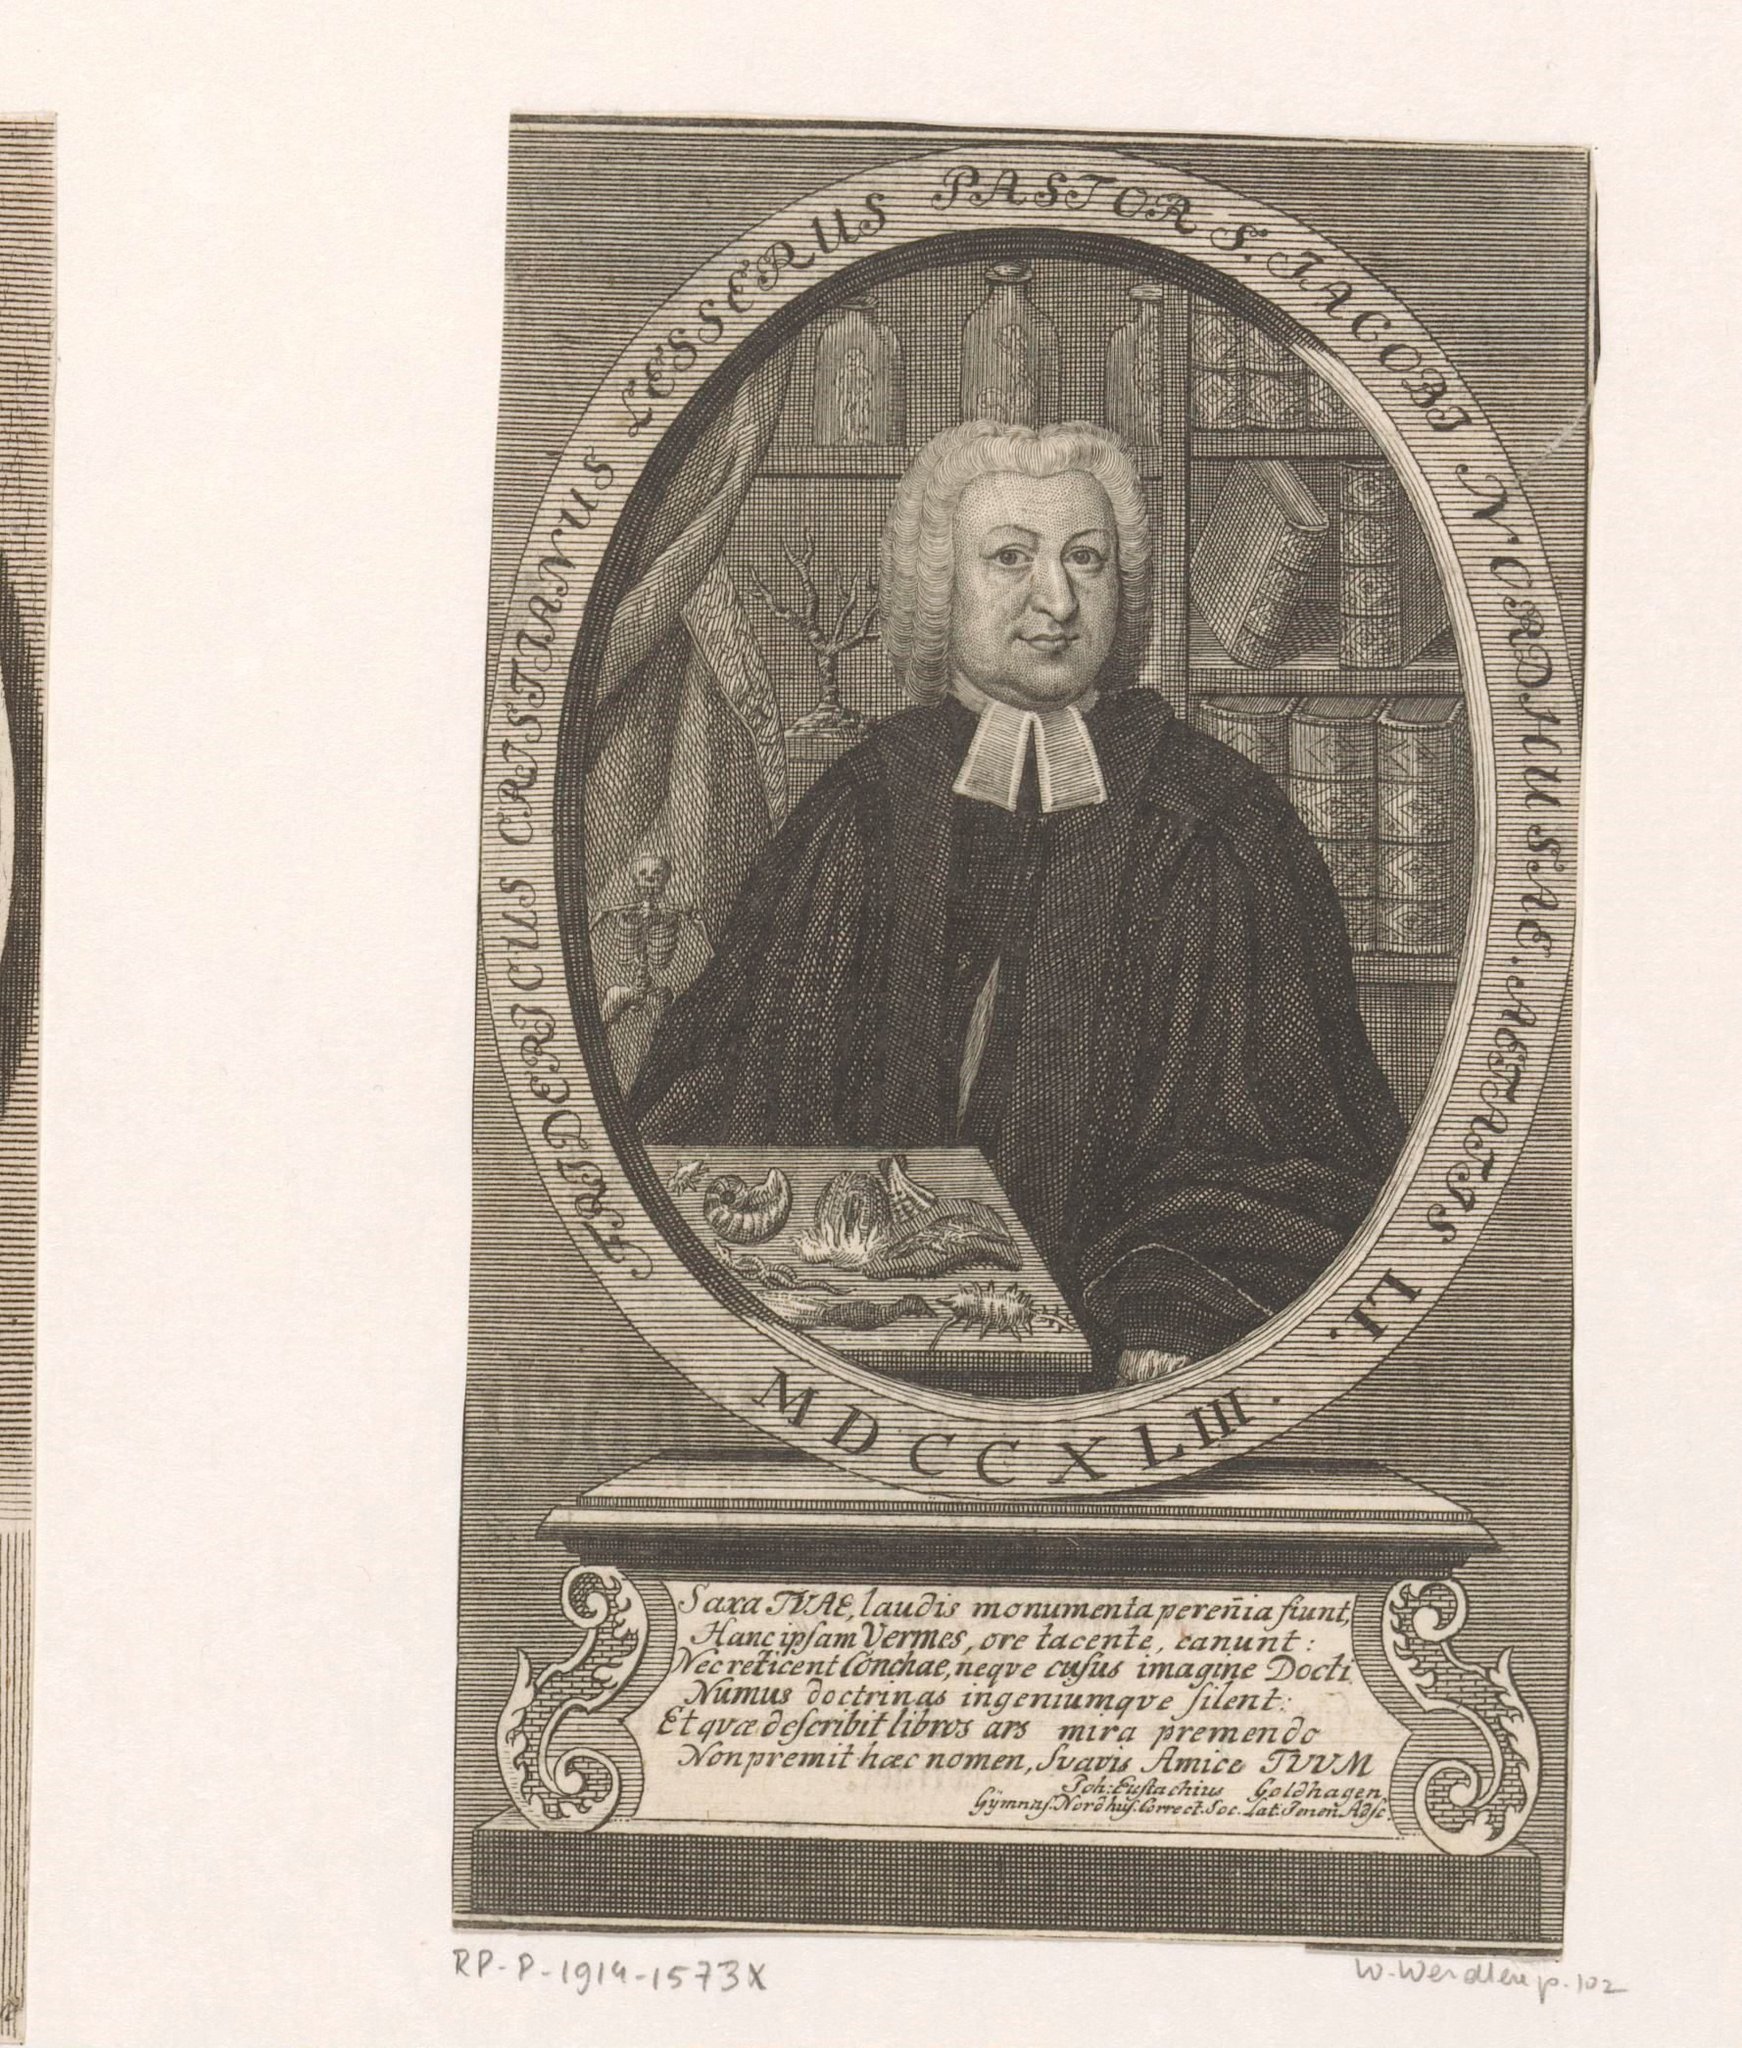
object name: print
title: Portret van Friedrich Christian Lesser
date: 1744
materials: paper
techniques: engraving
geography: nordhausen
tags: bookshelves, coelenterata: coral, historical persons, biology (+ portrait of scholar, scientist)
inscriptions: collector's mark: Lugt 2228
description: Prent ook gebruikt in: Lesser, Friedrich Christian. Testaceo-Theologia, Oder: Gründlicher Beweis des Daseyns und der vollkommnesten Eigenschaften eines göttlichen Wesens, Aus natürlicher und geistlicher Betrachtung Der Schnecken und Muscheln (...). Leipzig: Michael Blochberger, 1744.